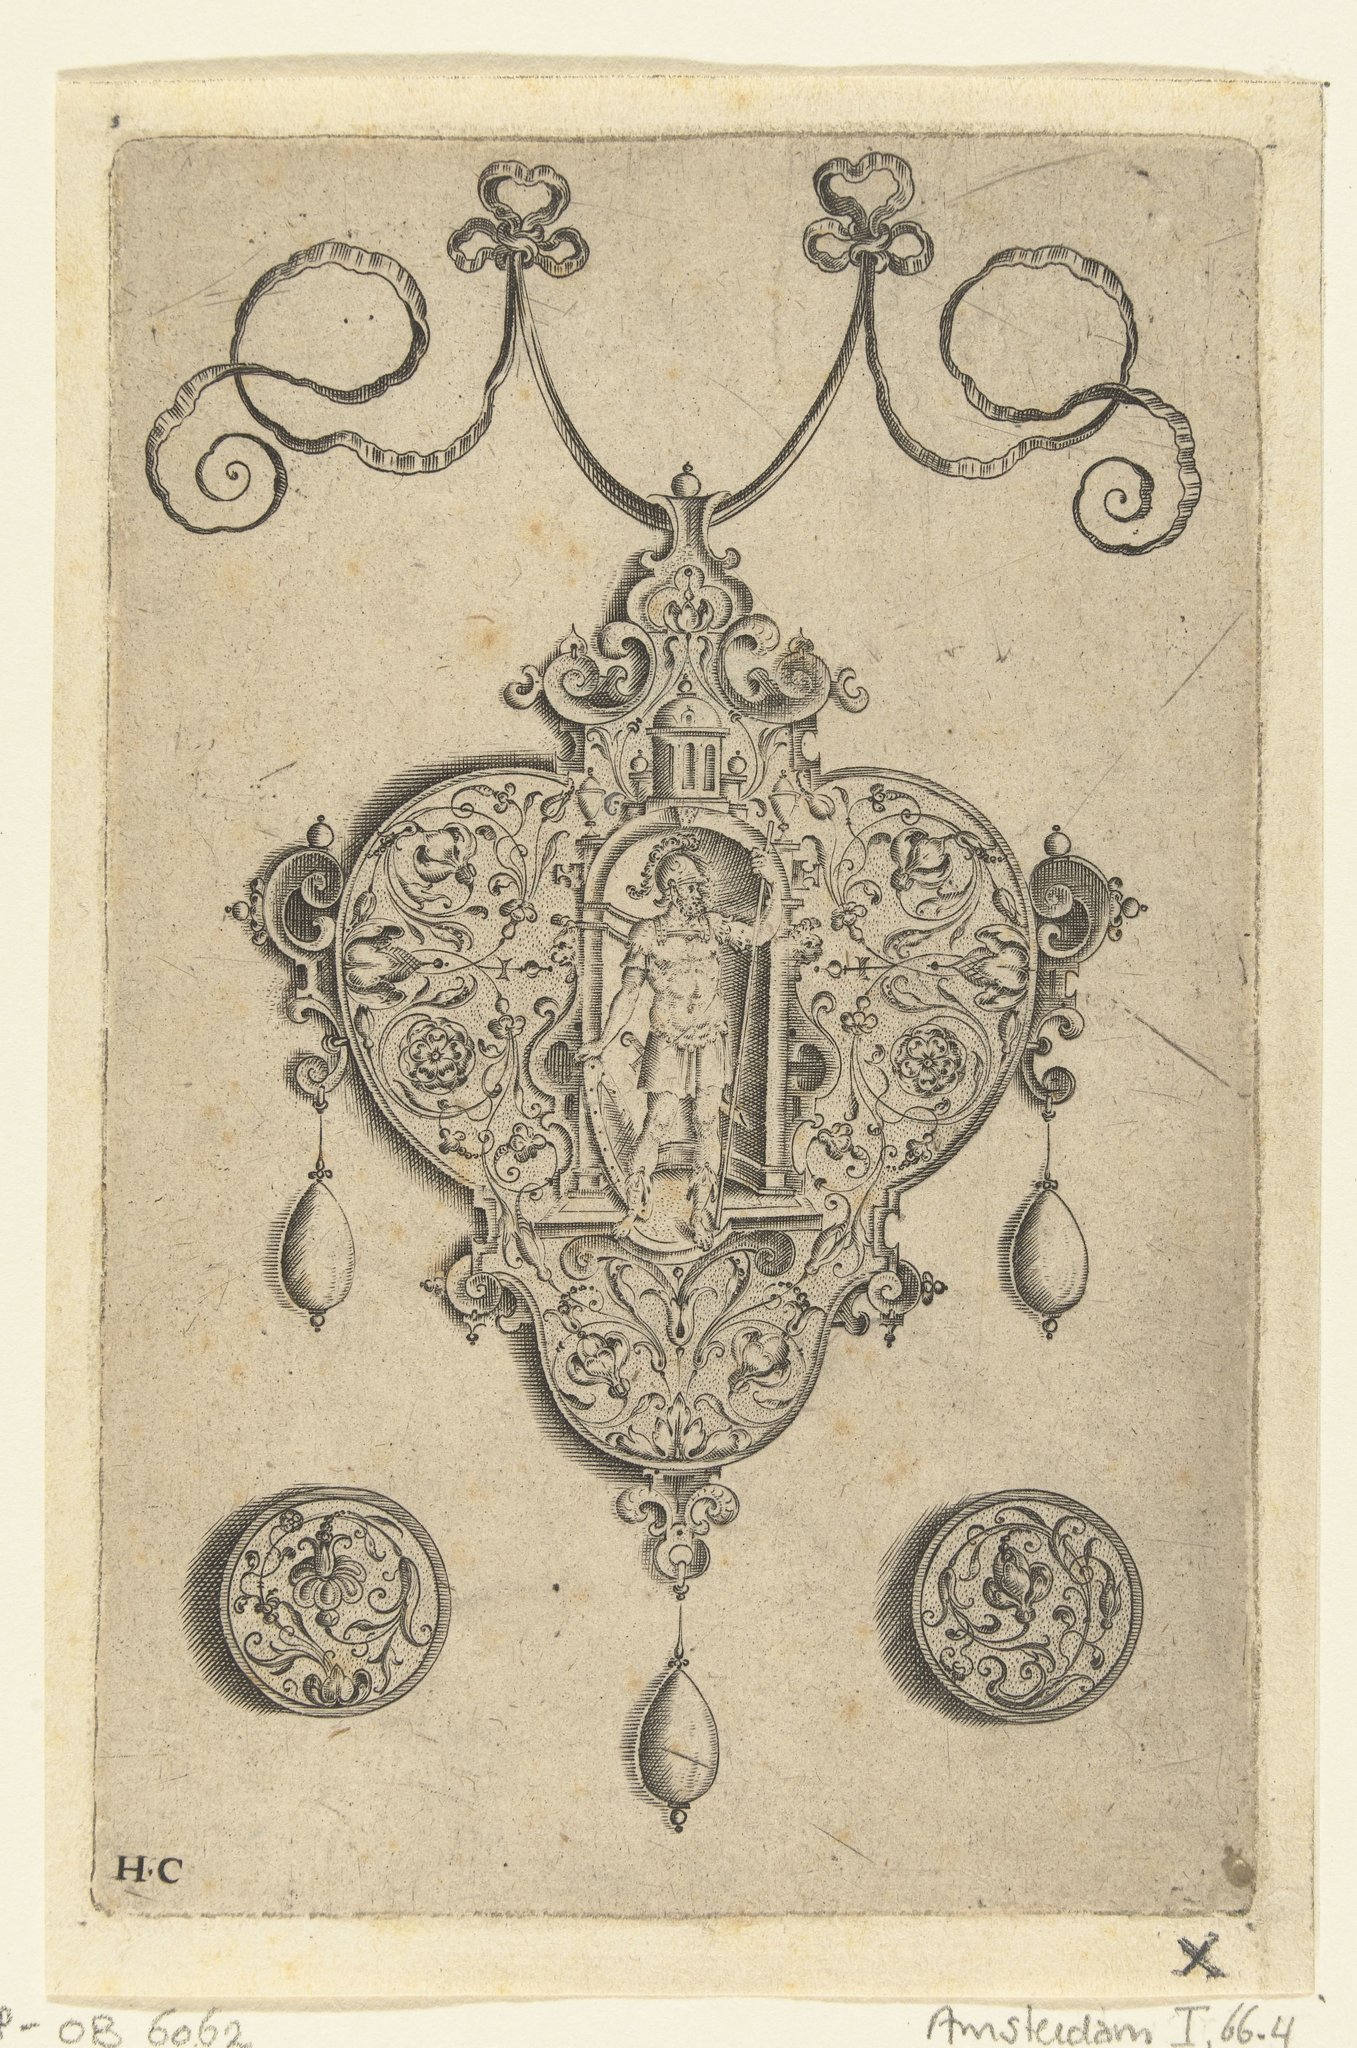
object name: ornament print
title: Hangers met arabesken en figuren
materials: paper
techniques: engraving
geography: netherlands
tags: (story of) mars (ares), pendant, trinket, 'breloque'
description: In het midden van een halfronde nis staat Mars, met speer en schild. Linksonder en rechtsonder een rond kostuumornament. Een van 6 bladen afkomstig uit een serie van 10 bladen met hangers. Aan iedere hanger hangen drie parels. Op elk blad bovendien nog twee of vier kleine kostuumornamenten.